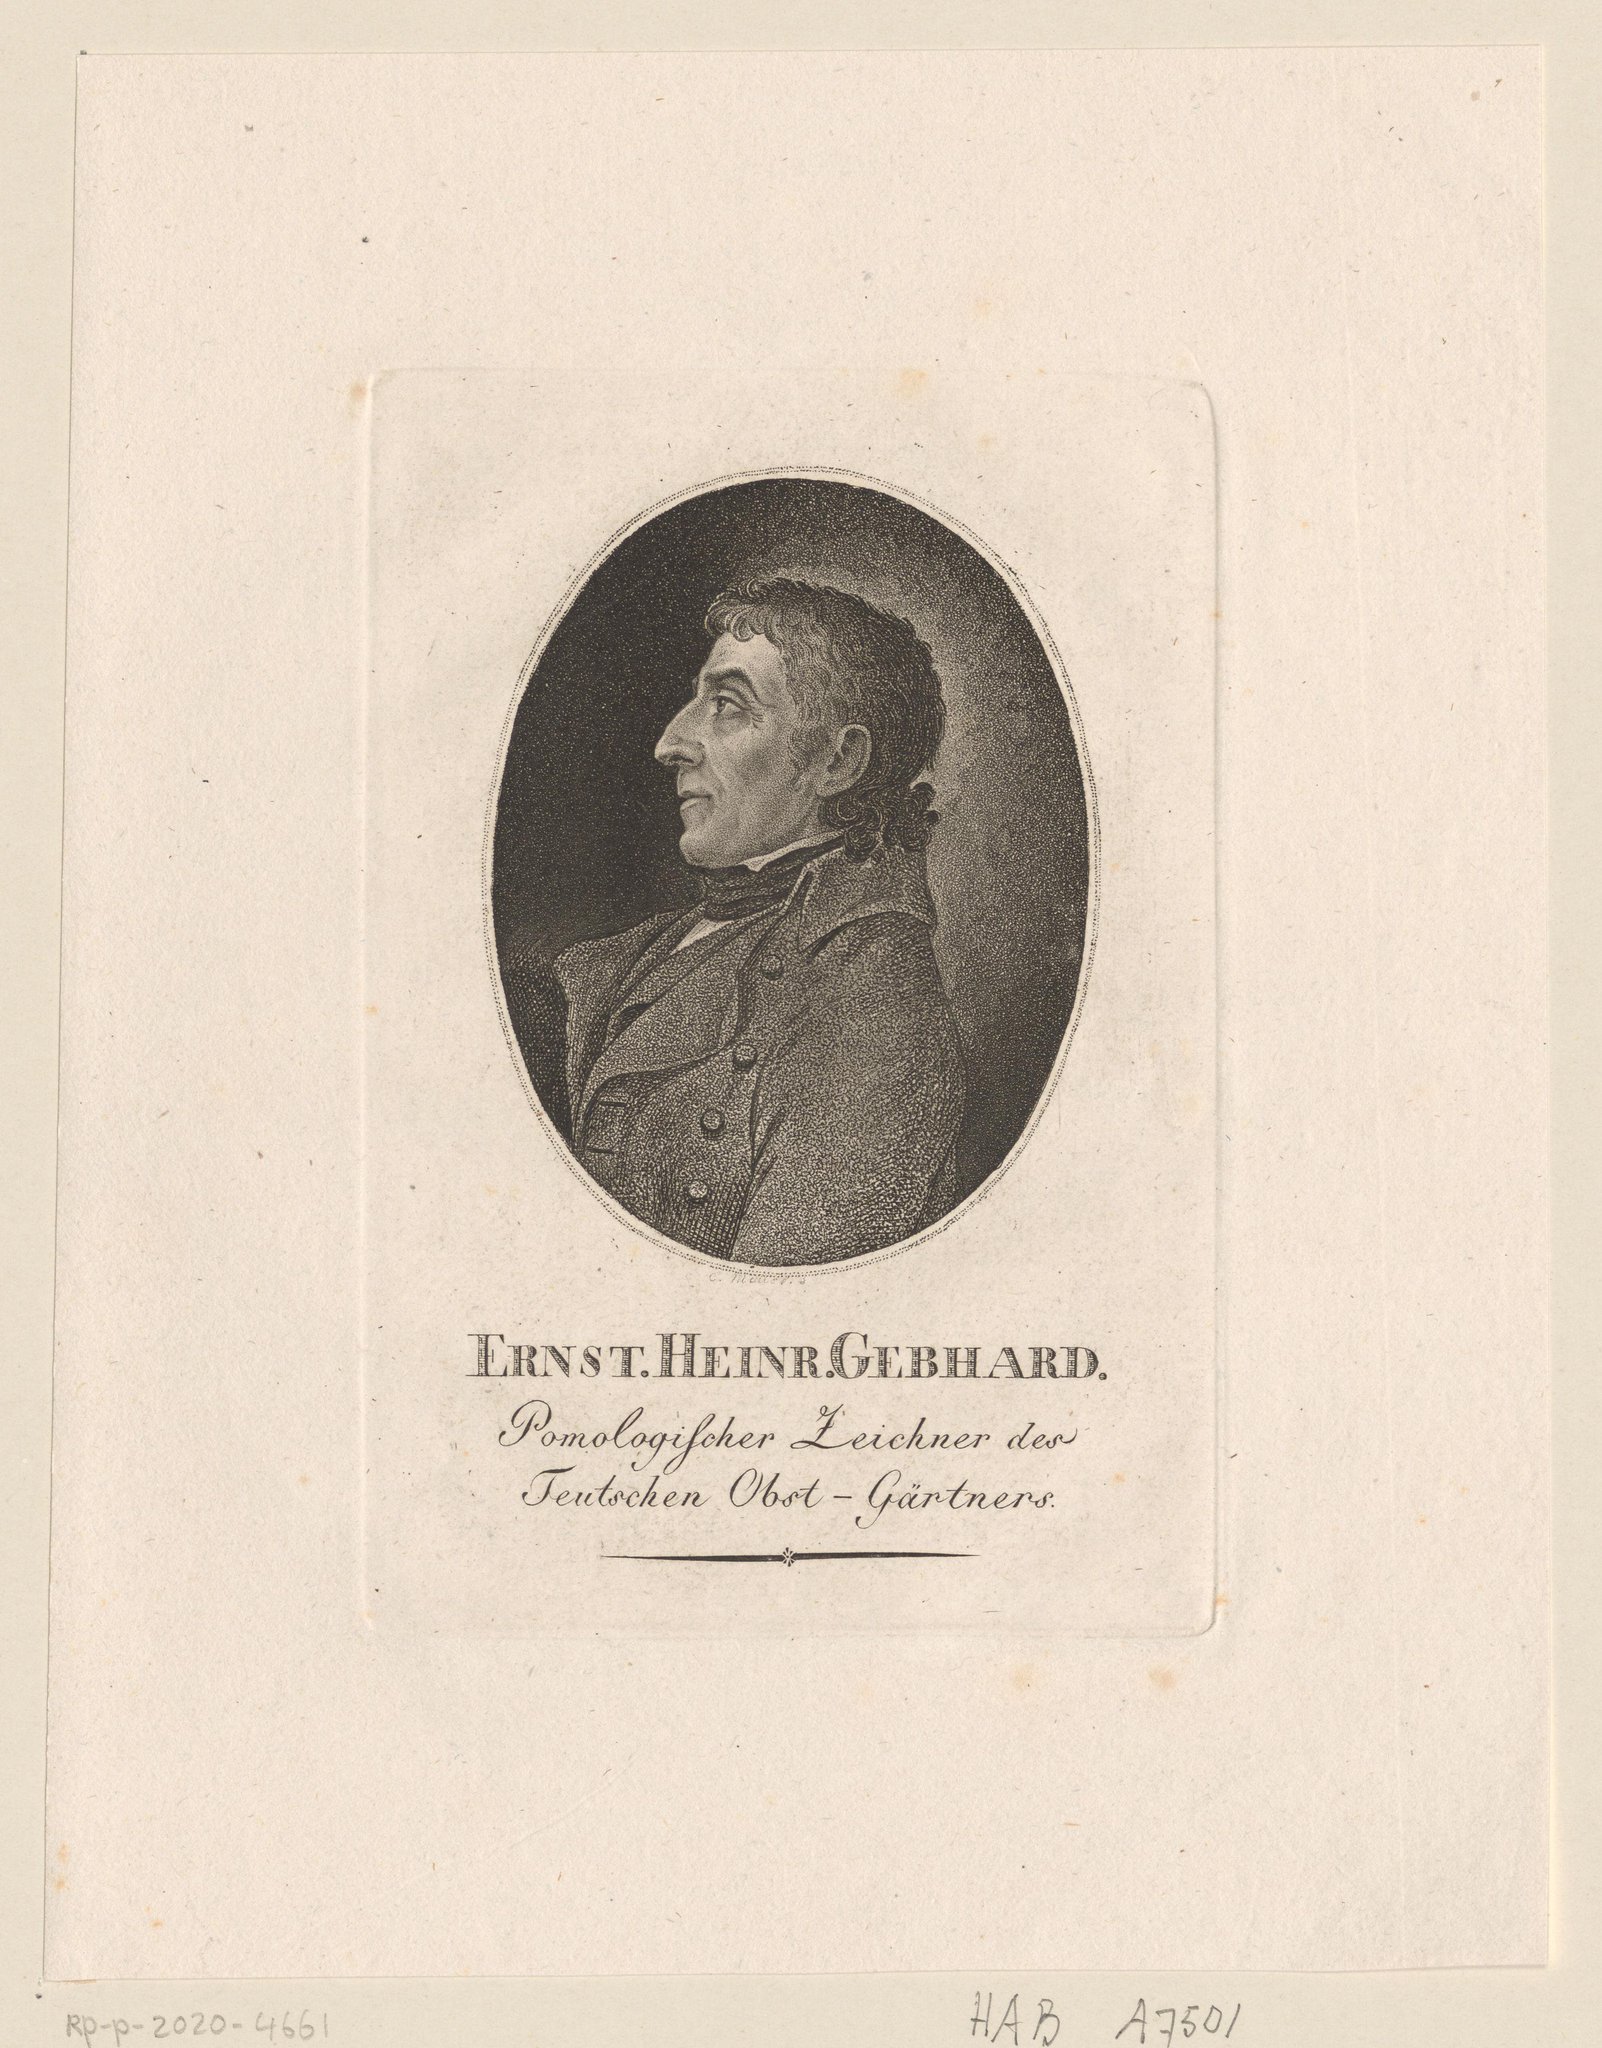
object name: print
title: Portret van Ernst Heinrich Gebhard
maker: johann christian ernst müller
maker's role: draughtsman, print maker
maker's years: 1766-1824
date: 1776-1824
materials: paper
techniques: stippling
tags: botany (+ portrait of scholar, scientist), historical persons